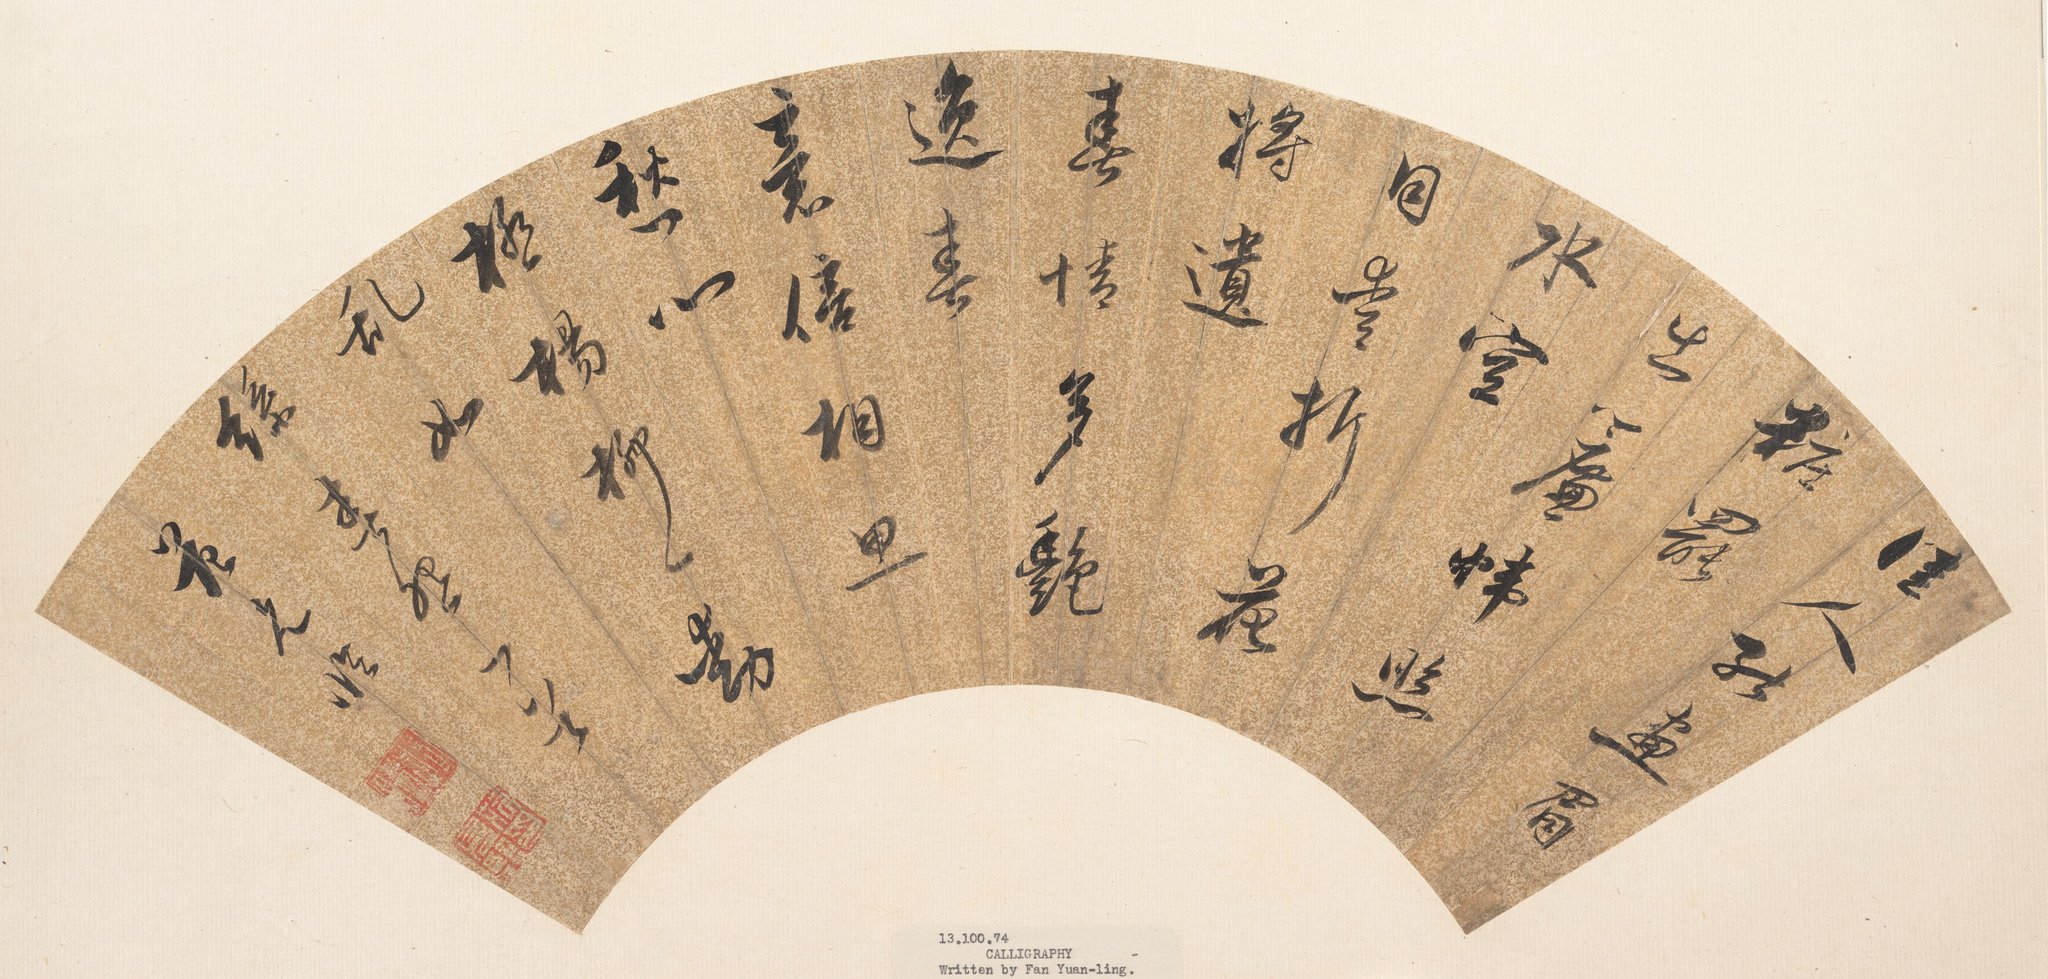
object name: folding fan mounted a an album leaf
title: Calligraphy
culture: chinese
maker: fan yunlin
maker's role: artist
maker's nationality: chinese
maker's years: 1558-1641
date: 1558-1641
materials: gold, ink, paper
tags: calligraphy